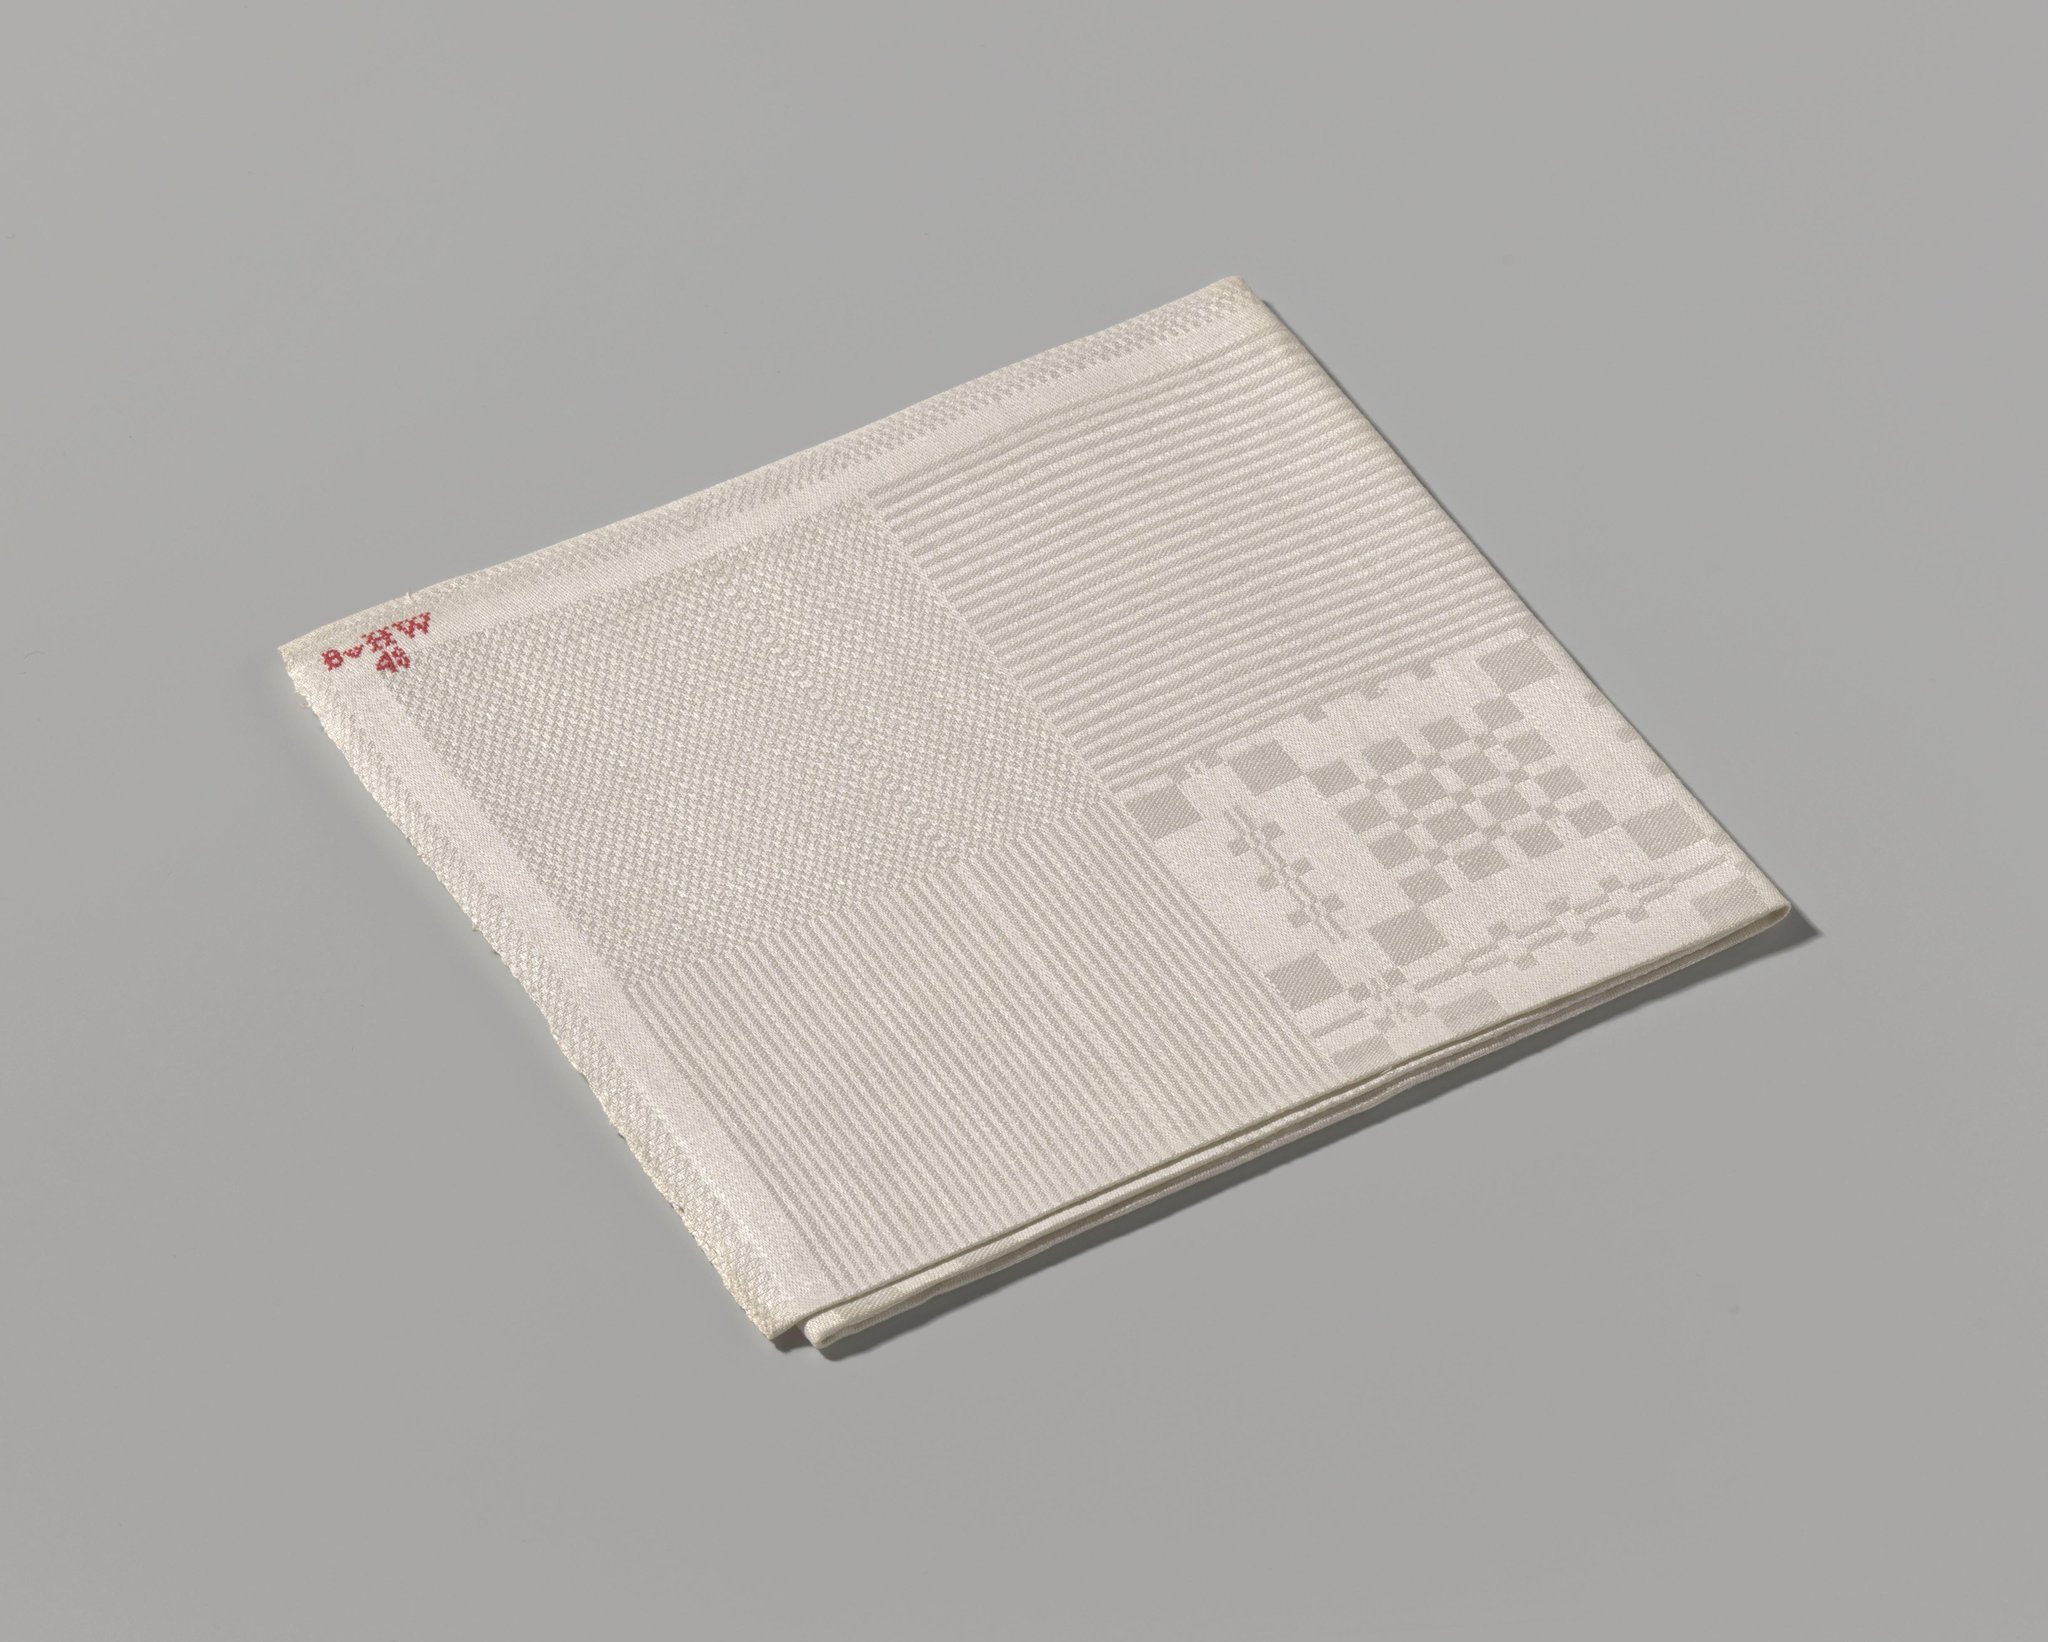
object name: napkin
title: Servet van wit linnendamast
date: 1880-1910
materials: linen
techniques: damask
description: Wit linnen damasten servet met pellen patroon, merk BvHW 48.